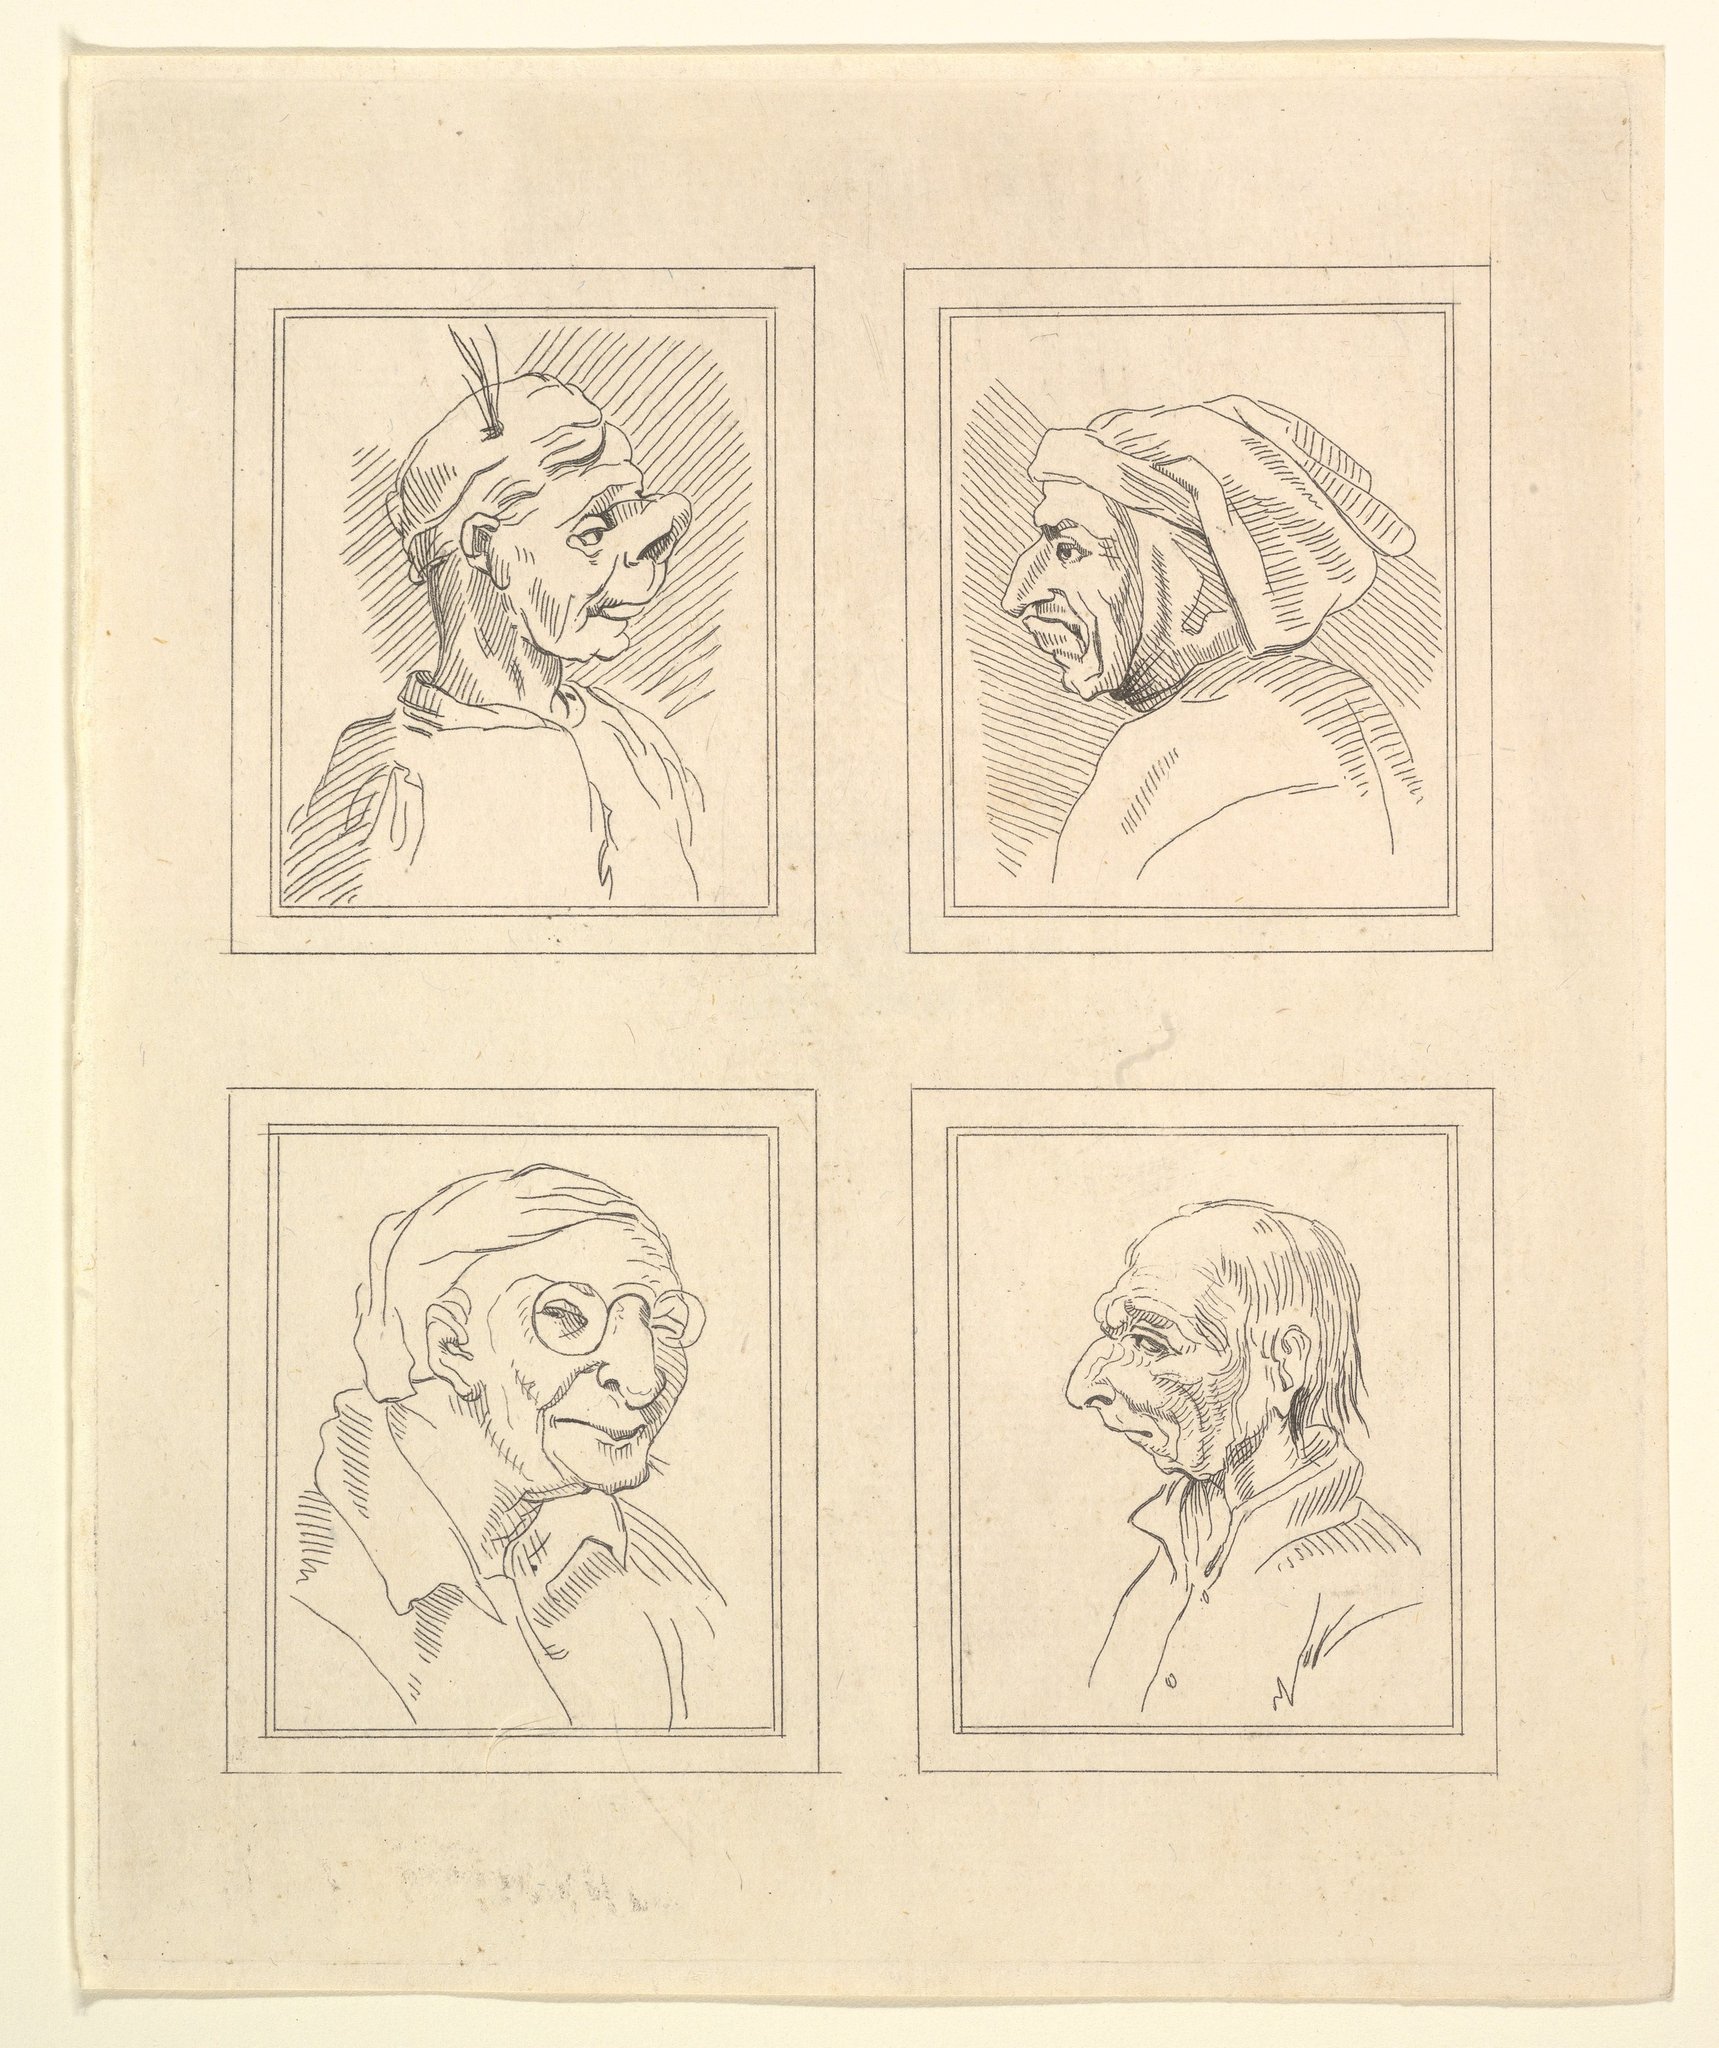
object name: print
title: Four Heads (from Characaturas by Leonardo da Vinci, from Drawings by Wincelslaus Hollar, out of the Portland Museum)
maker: wenceslaus hollar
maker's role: artist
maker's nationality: bohemian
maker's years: 1607-1677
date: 1786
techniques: etching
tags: heads,men